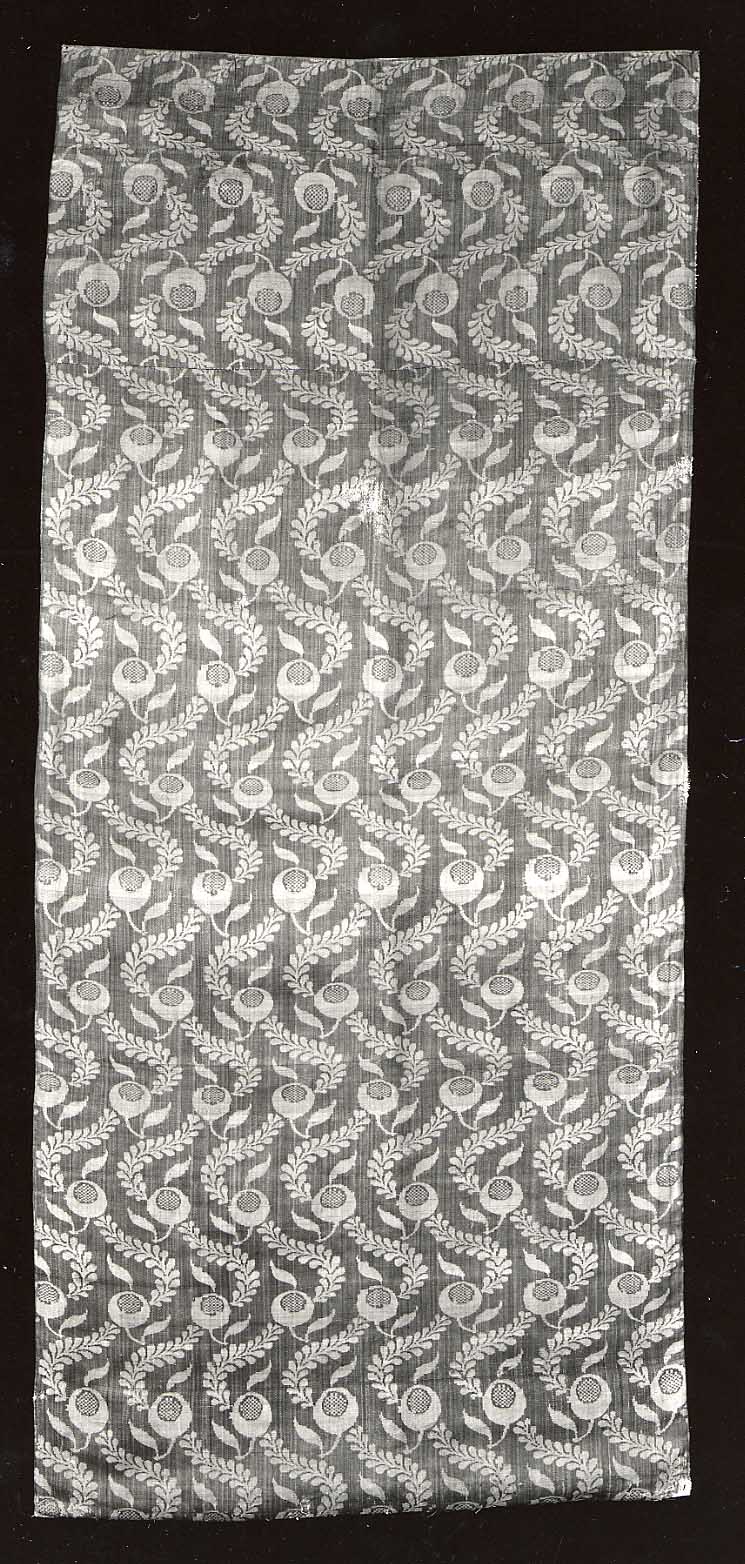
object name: textile panel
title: Panel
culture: french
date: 1701-1800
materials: cotton, silk